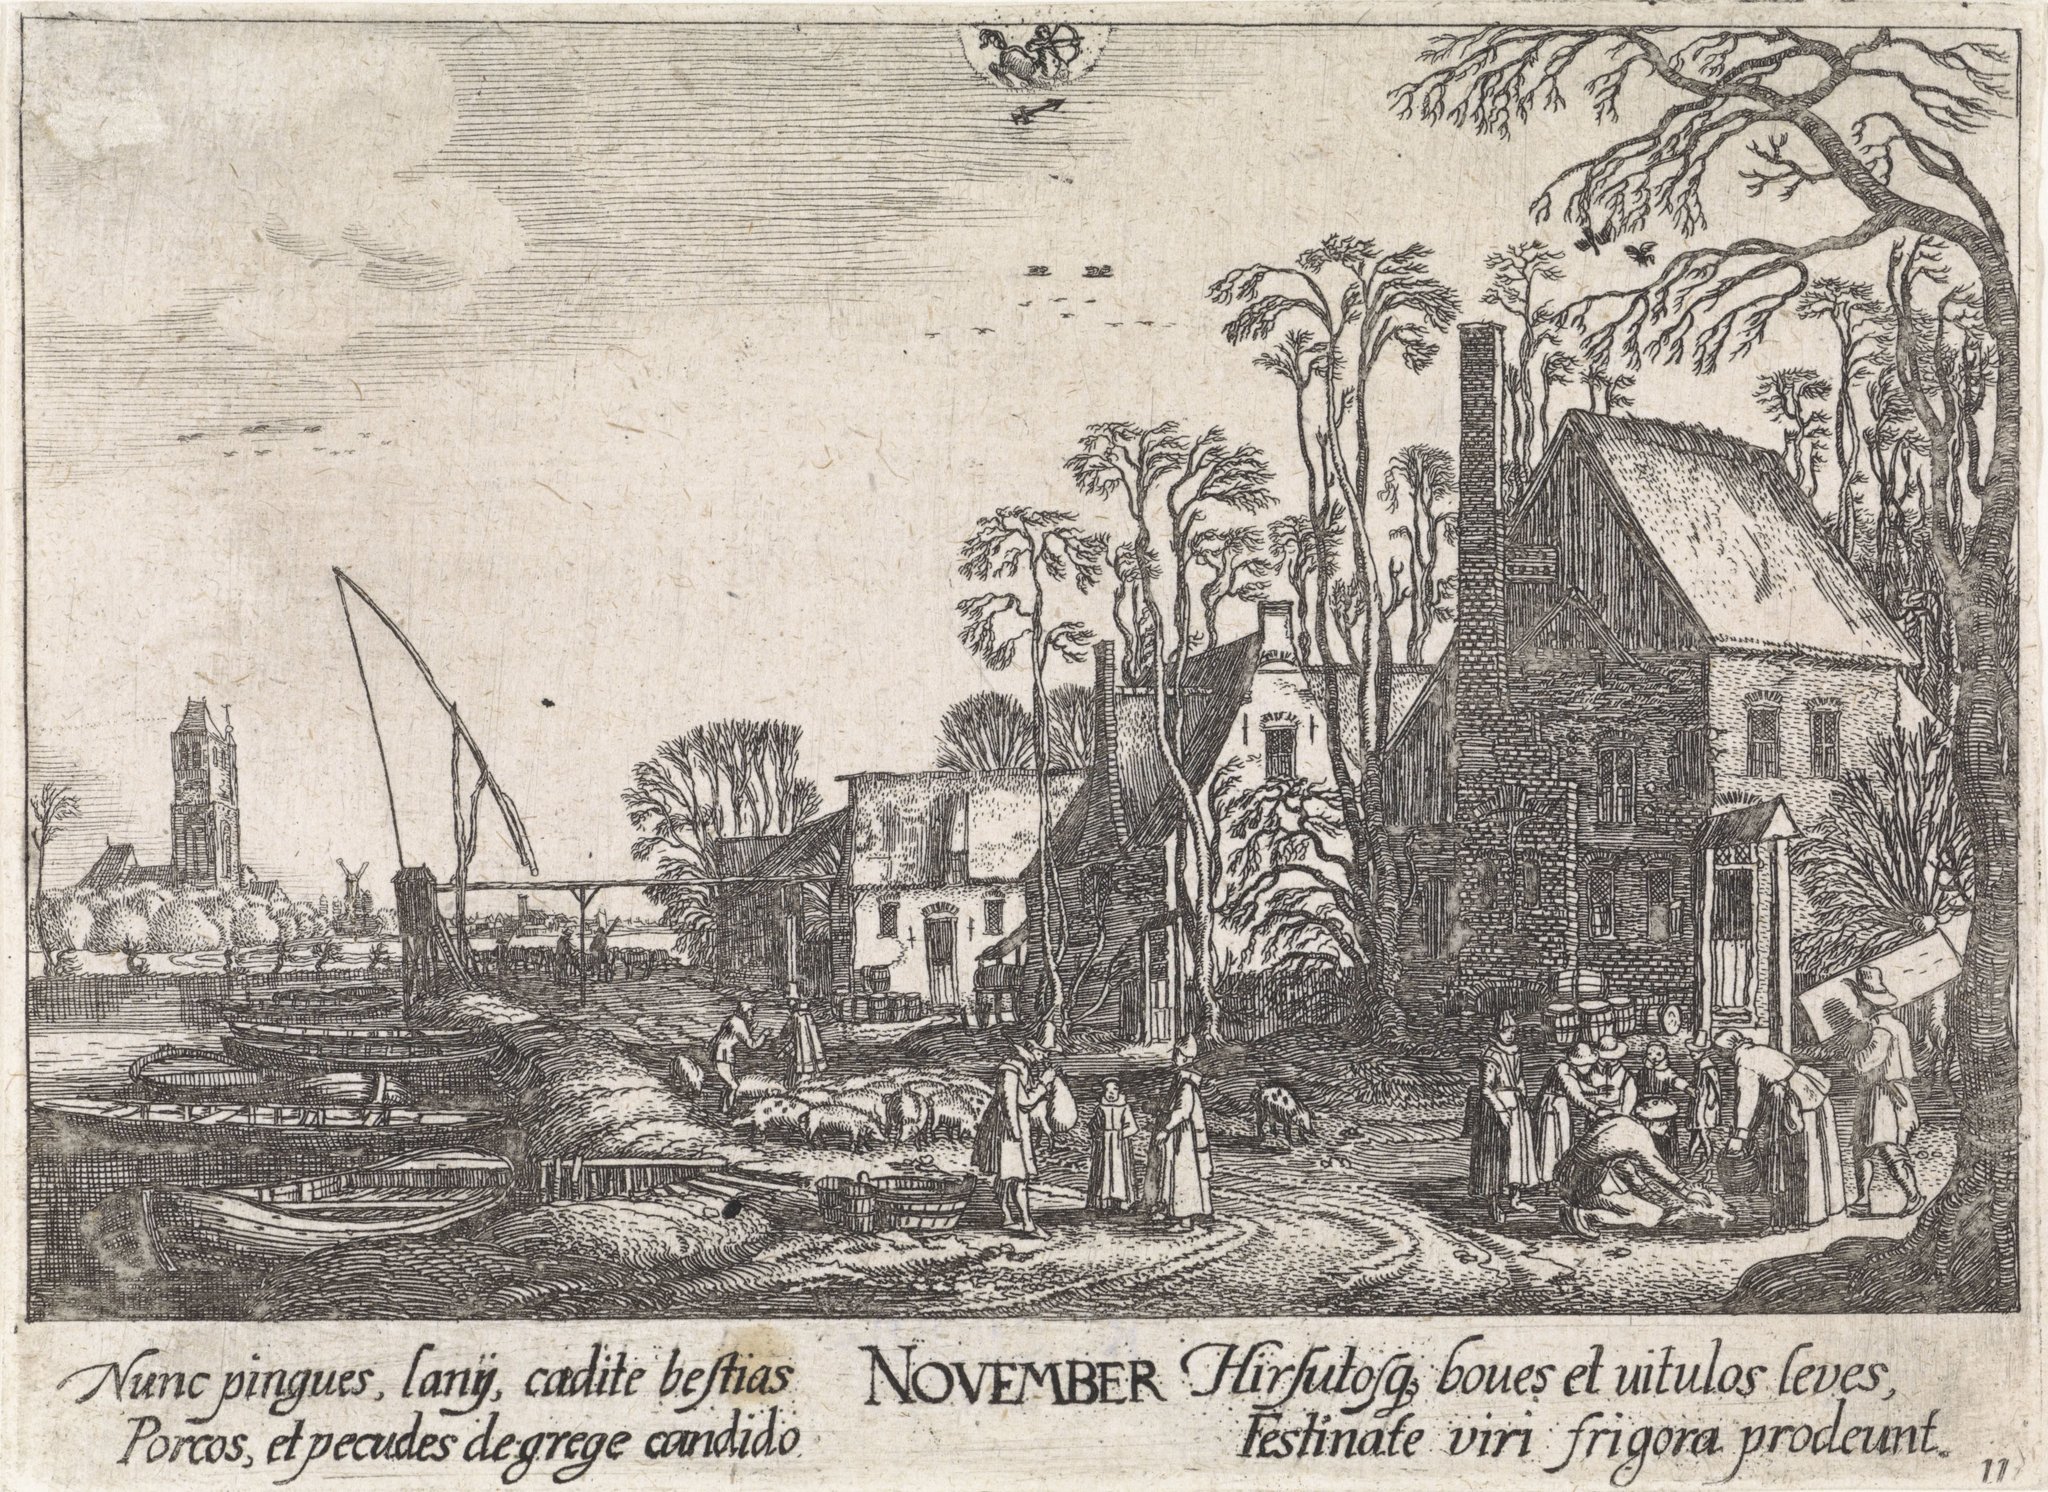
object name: print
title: De twaalf maanden, met dorpsgezichten, kopieën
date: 1684-1729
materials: paper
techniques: etching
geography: germany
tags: landscape symbolizing november, pig, brewer (+ place ~ crafts, industries, agriculture), november and its 'labours', sagittarius (zodiacal sign of november), butcher, slaughterman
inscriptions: collector's mark: Lugt 384, collector's mark: Lugt 3790, collector's mark: Lugt 2228, collector's mark: Lugt 2760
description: Landschap met vele figuren op een landweg waaronder een varkenshoeder met zijn kudde bij een dorp langs een rivier; voorstellende de maand november. Rechts wordt een varken geslacht voor een brouwerij. Langs de weg nog een brouwerij. Bovenaan het bij deze maand behorende sterrenbeeld: boogschutter. Elfde prent uit een serie van twaalf.